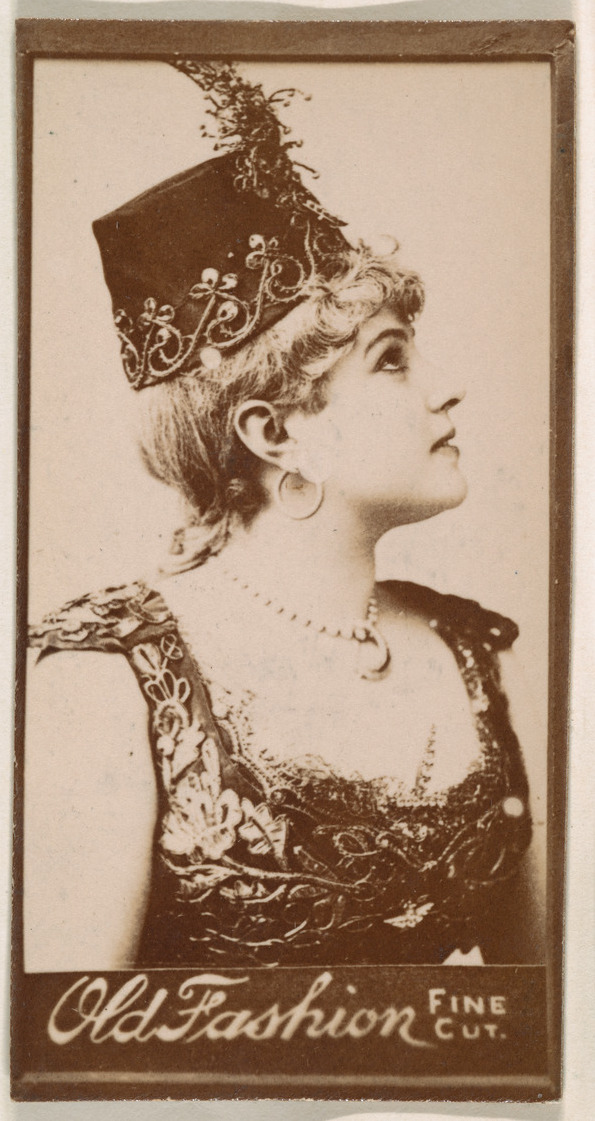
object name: photograph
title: Actress wearing feathered bodice, from the Actresses series (N664) promoting Old Fashion Fine Cut Tobacco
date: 1888-1890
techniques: albumen silver print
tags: portraits,profiles,women,actresses